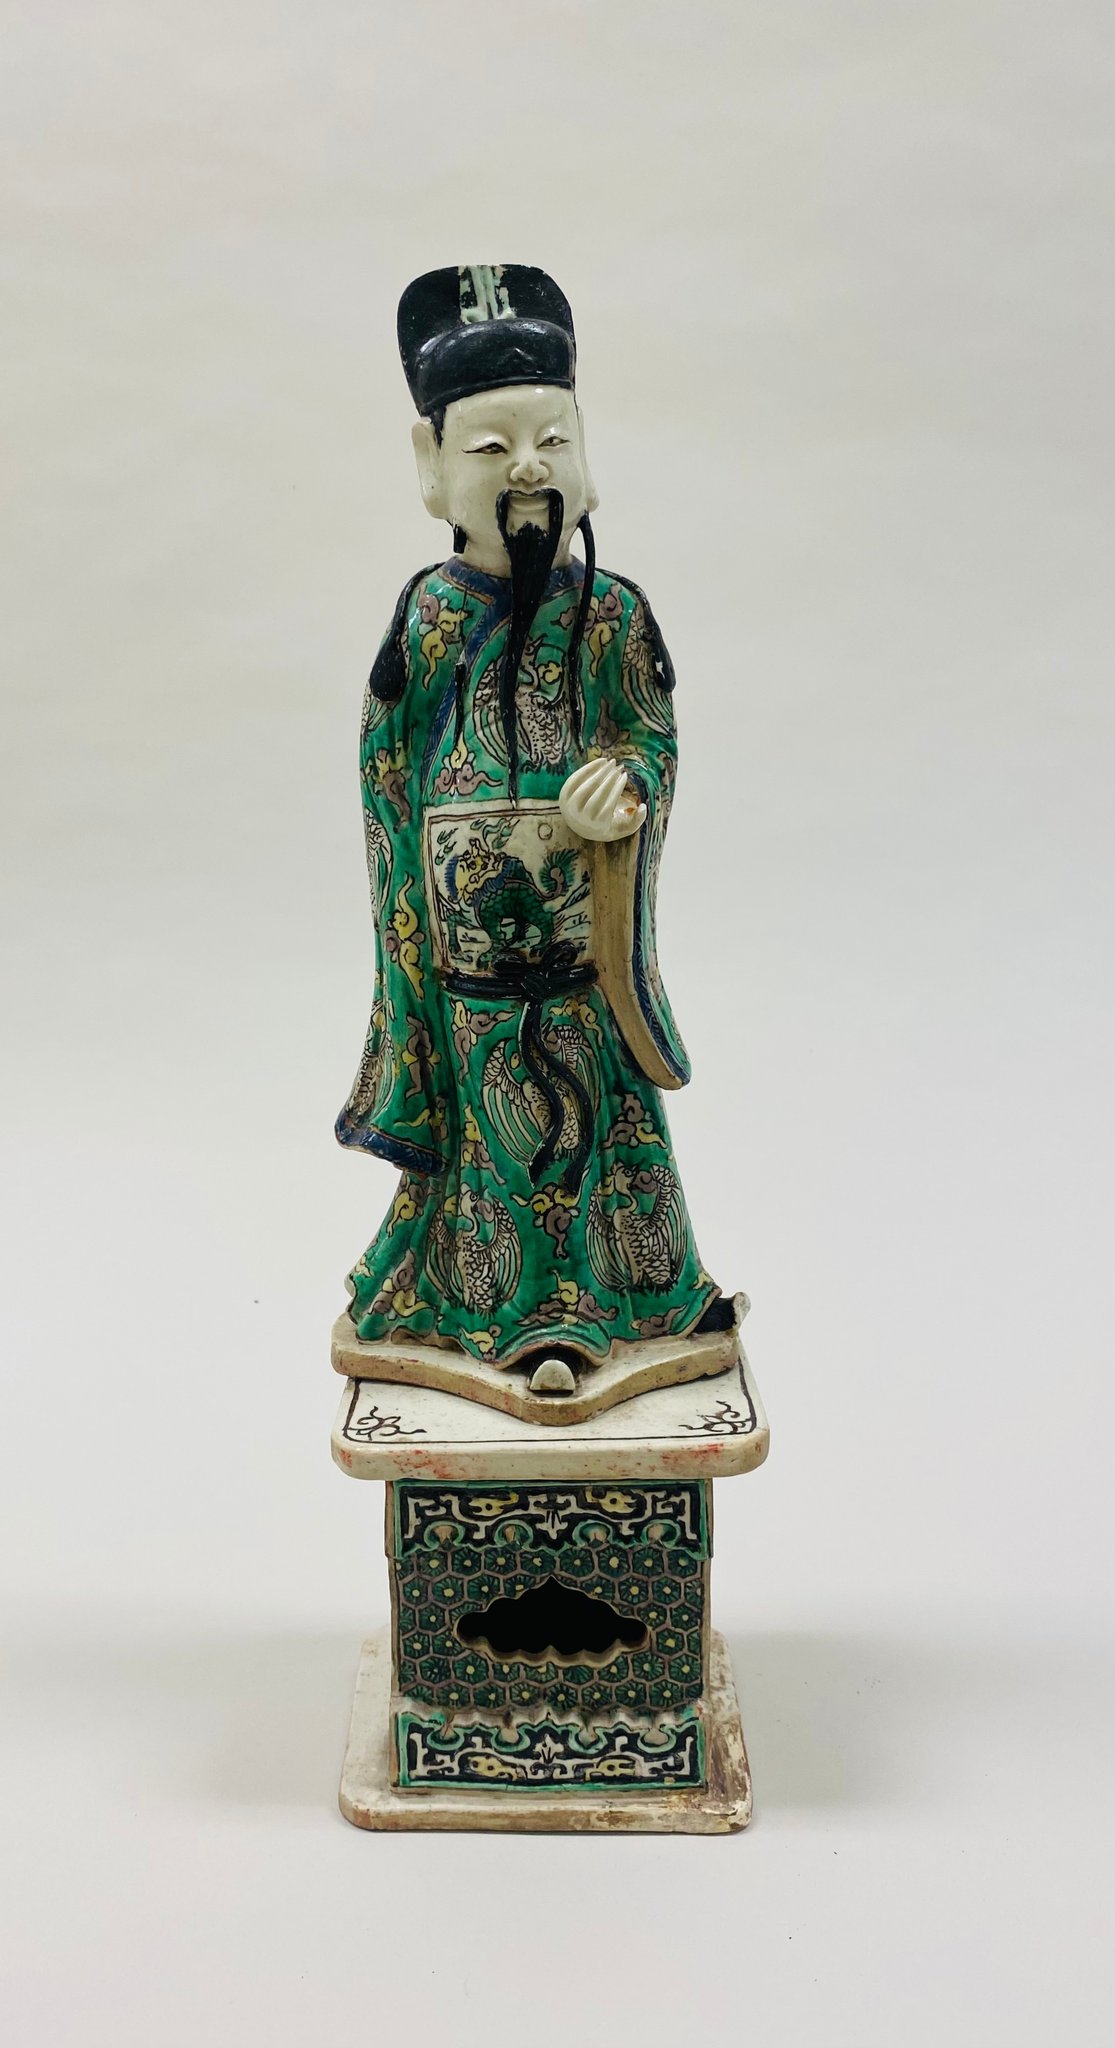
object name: figure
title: Mythological figure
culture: chinese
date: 1801-1900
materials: biscuit, enamel, porcelain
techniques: painting, polychrome